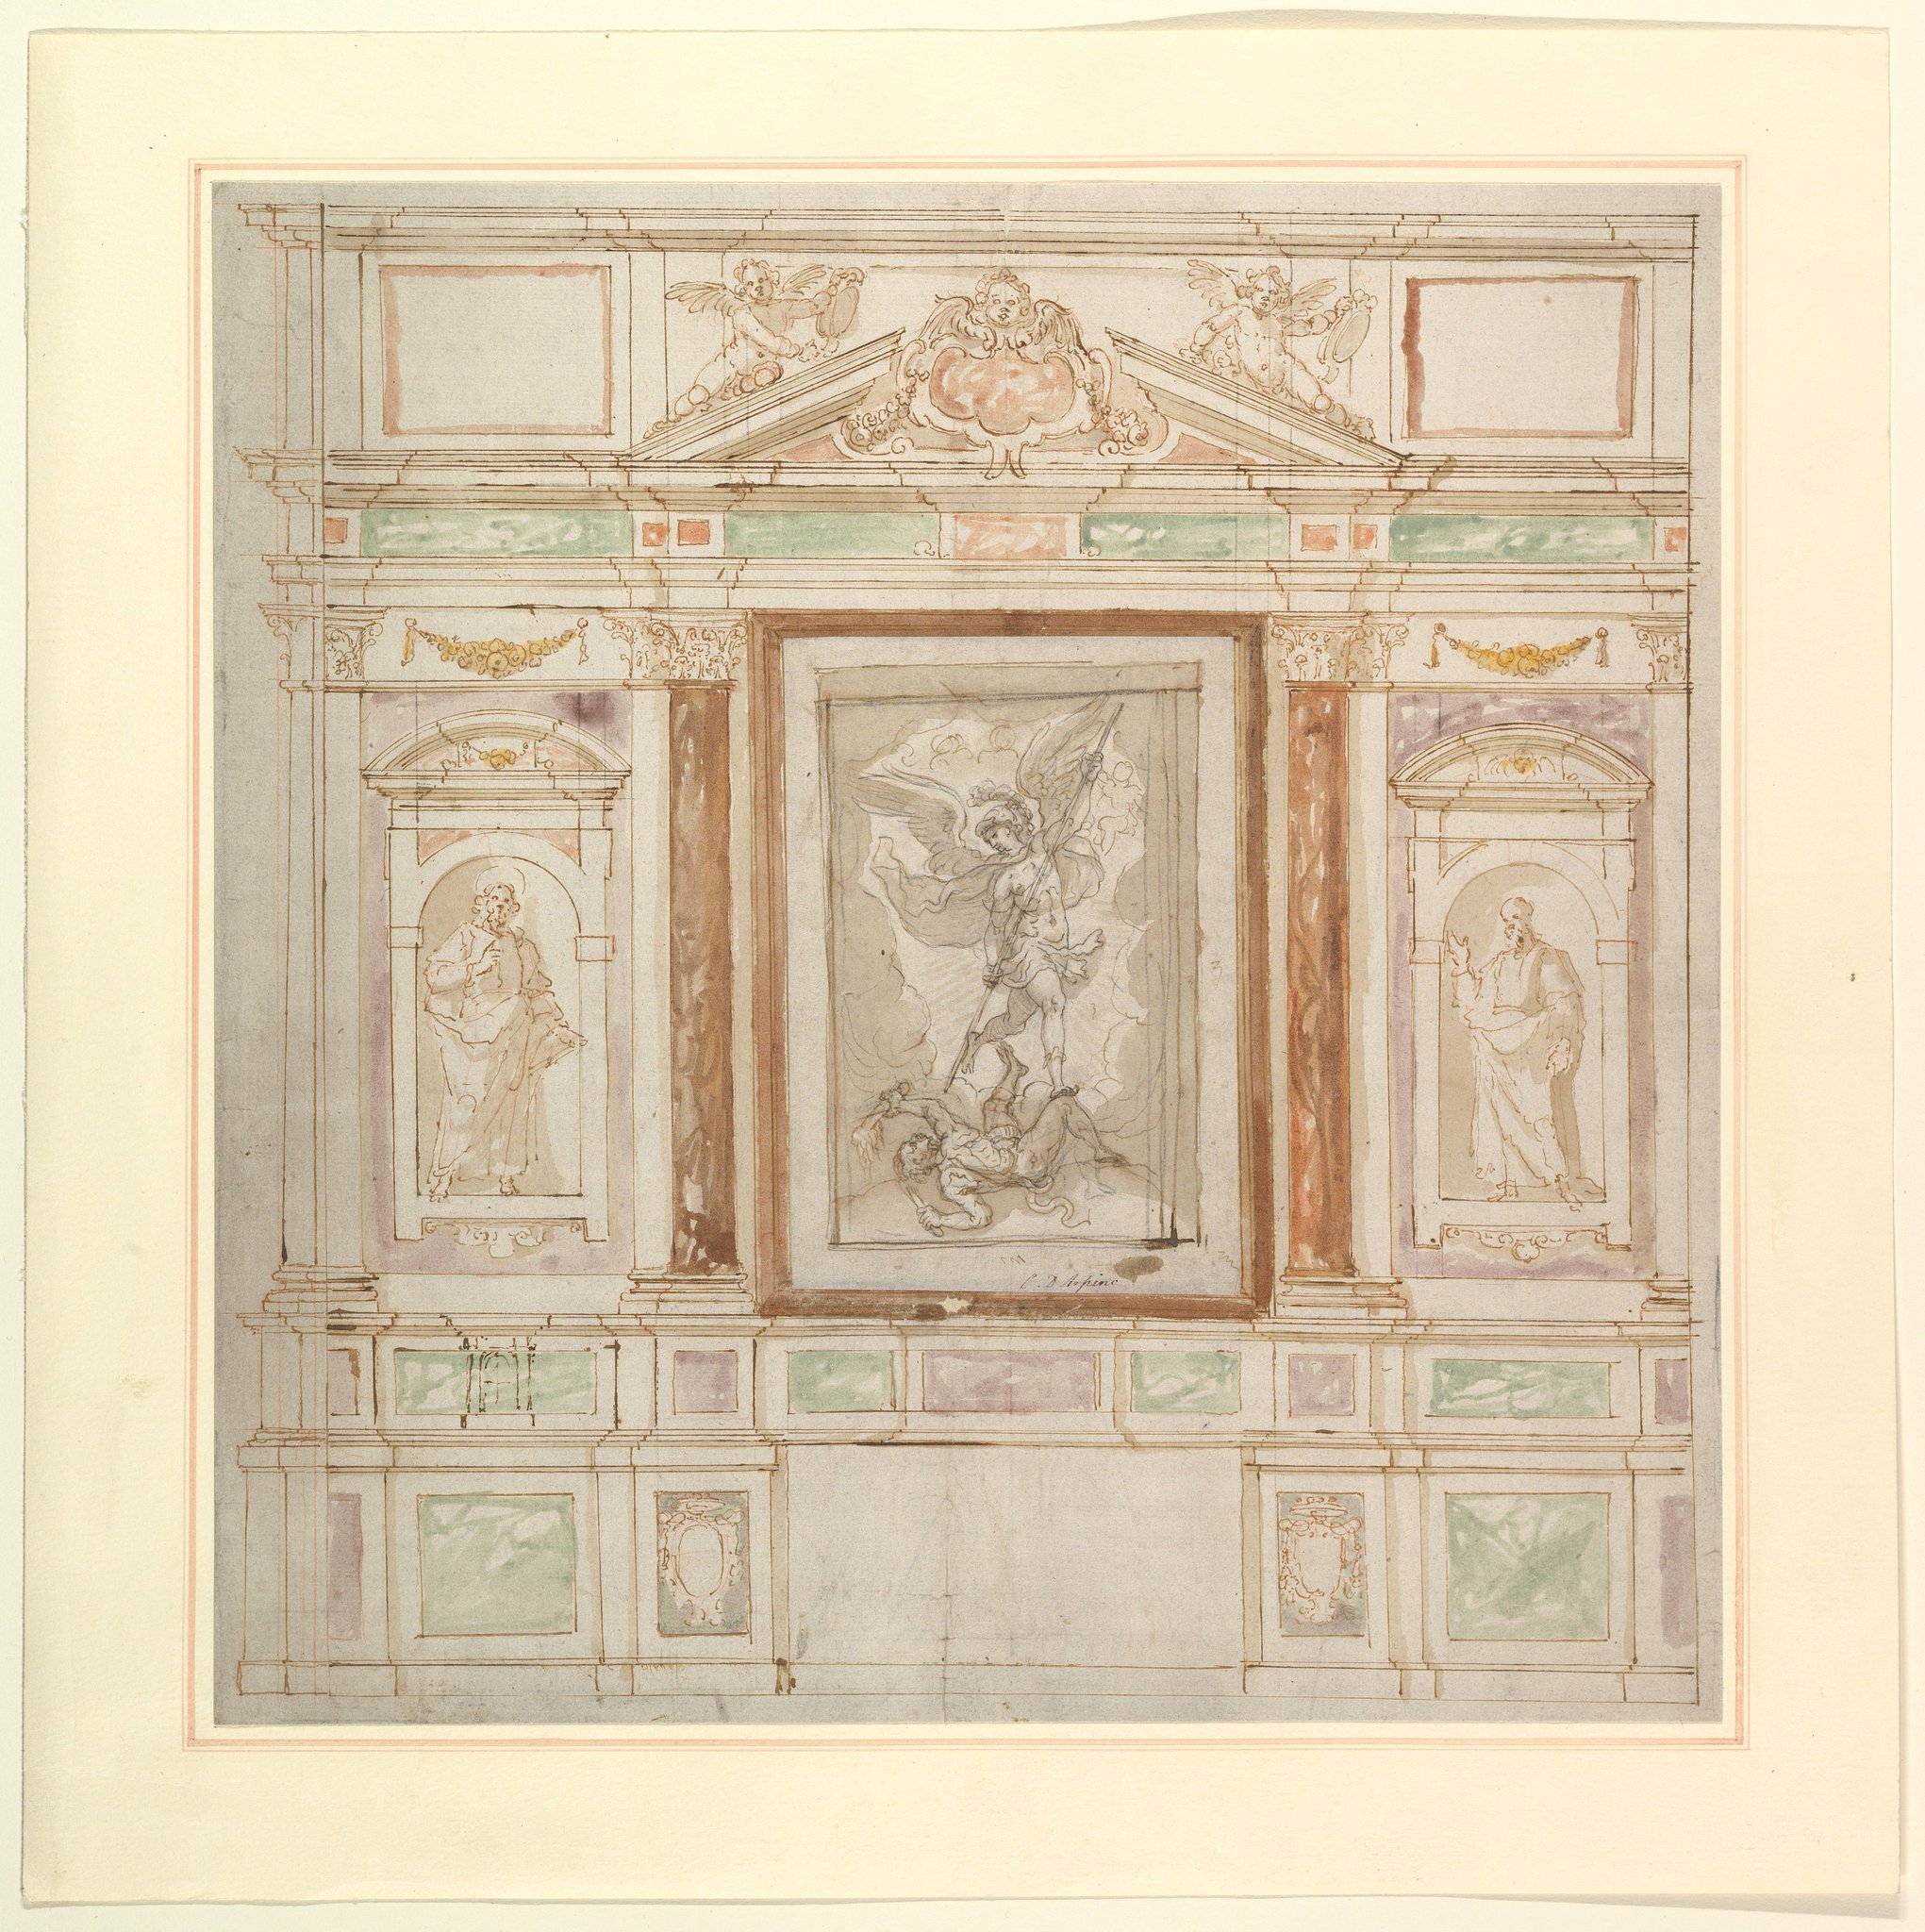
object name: drawing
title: Architectural Design for a Monumental Altar, with a Composition with Saint Michael Against Satan and two Saints (Saints Peter and Paul?)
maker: Anonymous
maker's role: artist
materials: chalk, ink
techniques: brush, pen, wash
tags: altars,angels,saint michael,saint paul,saint peter